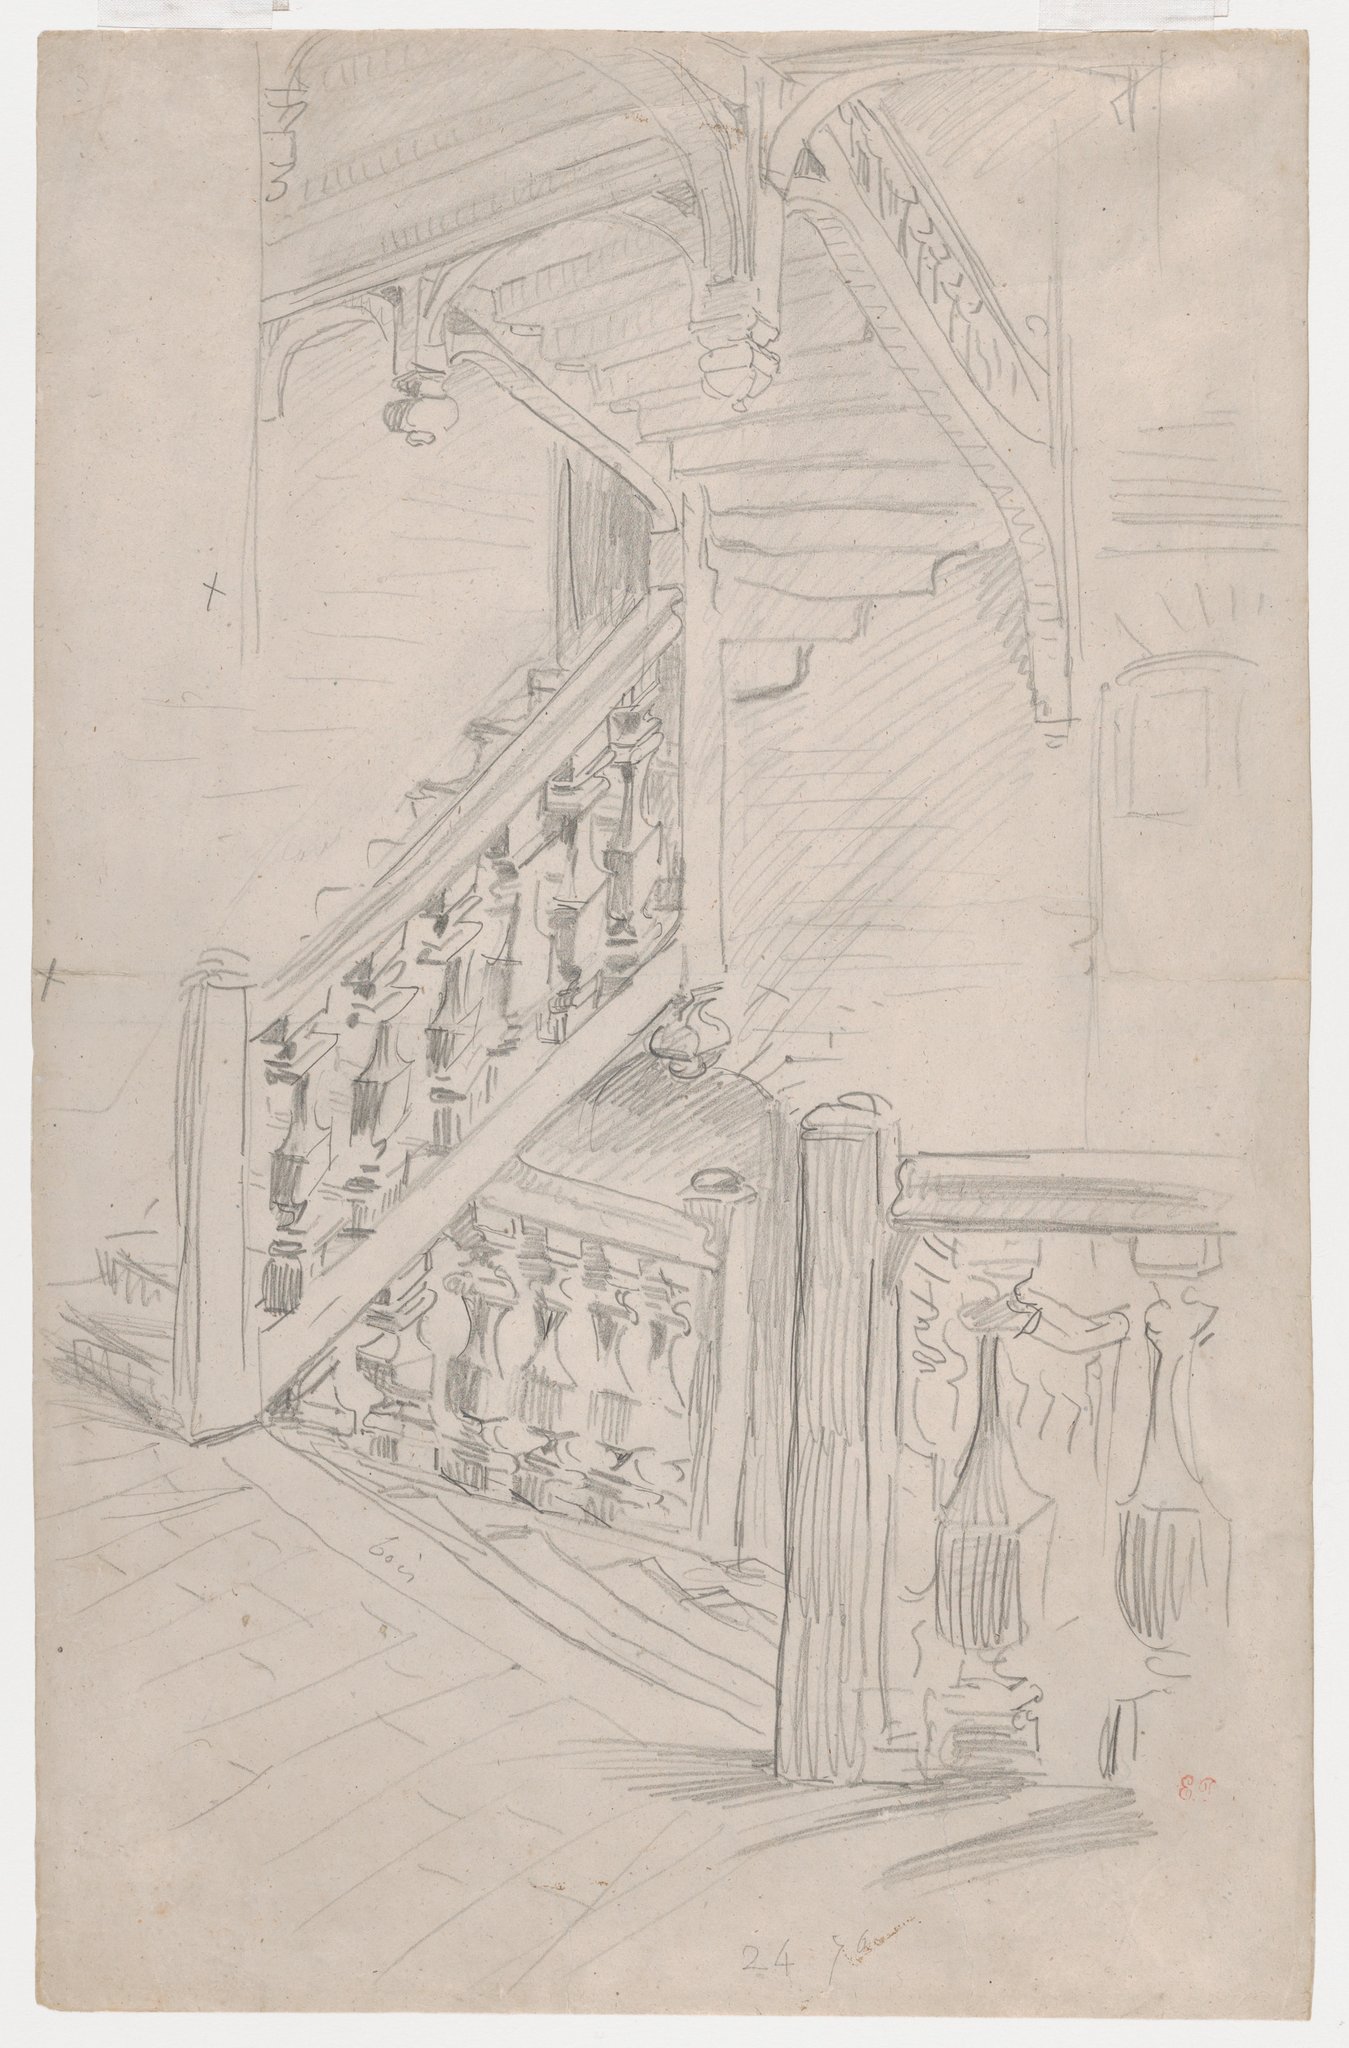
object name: drawing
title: Interior with Staircase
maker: eugène delacroix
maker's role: artist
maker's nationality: french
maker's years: 1798-1863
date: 1850-1859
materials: graphite